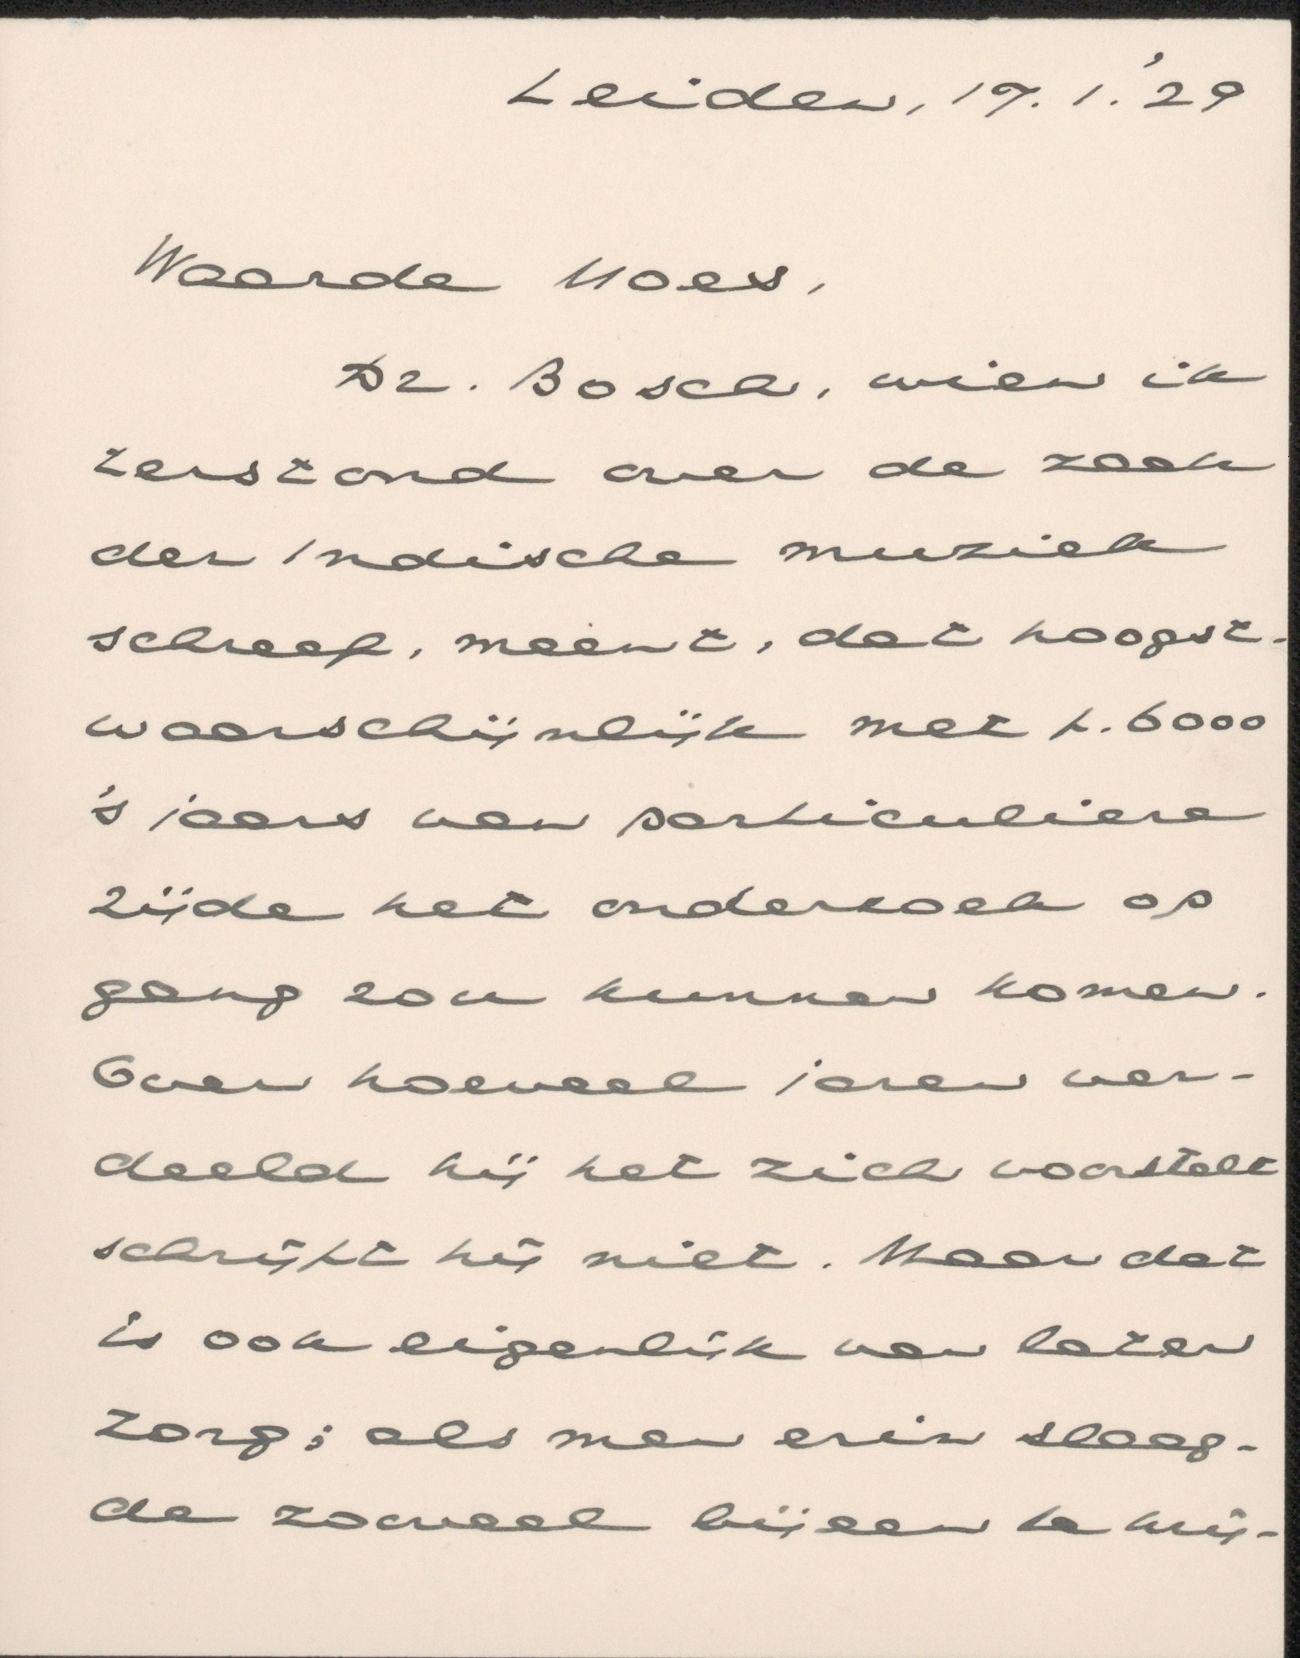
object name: letter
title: Brief aan Christiaan Moes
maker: johan huizinga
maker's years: 1872-1945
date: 1929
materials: ink, paper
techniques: pen, writing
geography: leiden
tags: engineer, leiden, the arts of the stage: ballet, theatre, musical drama, motion picture, money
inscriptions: collector's mark: ‘RPK’